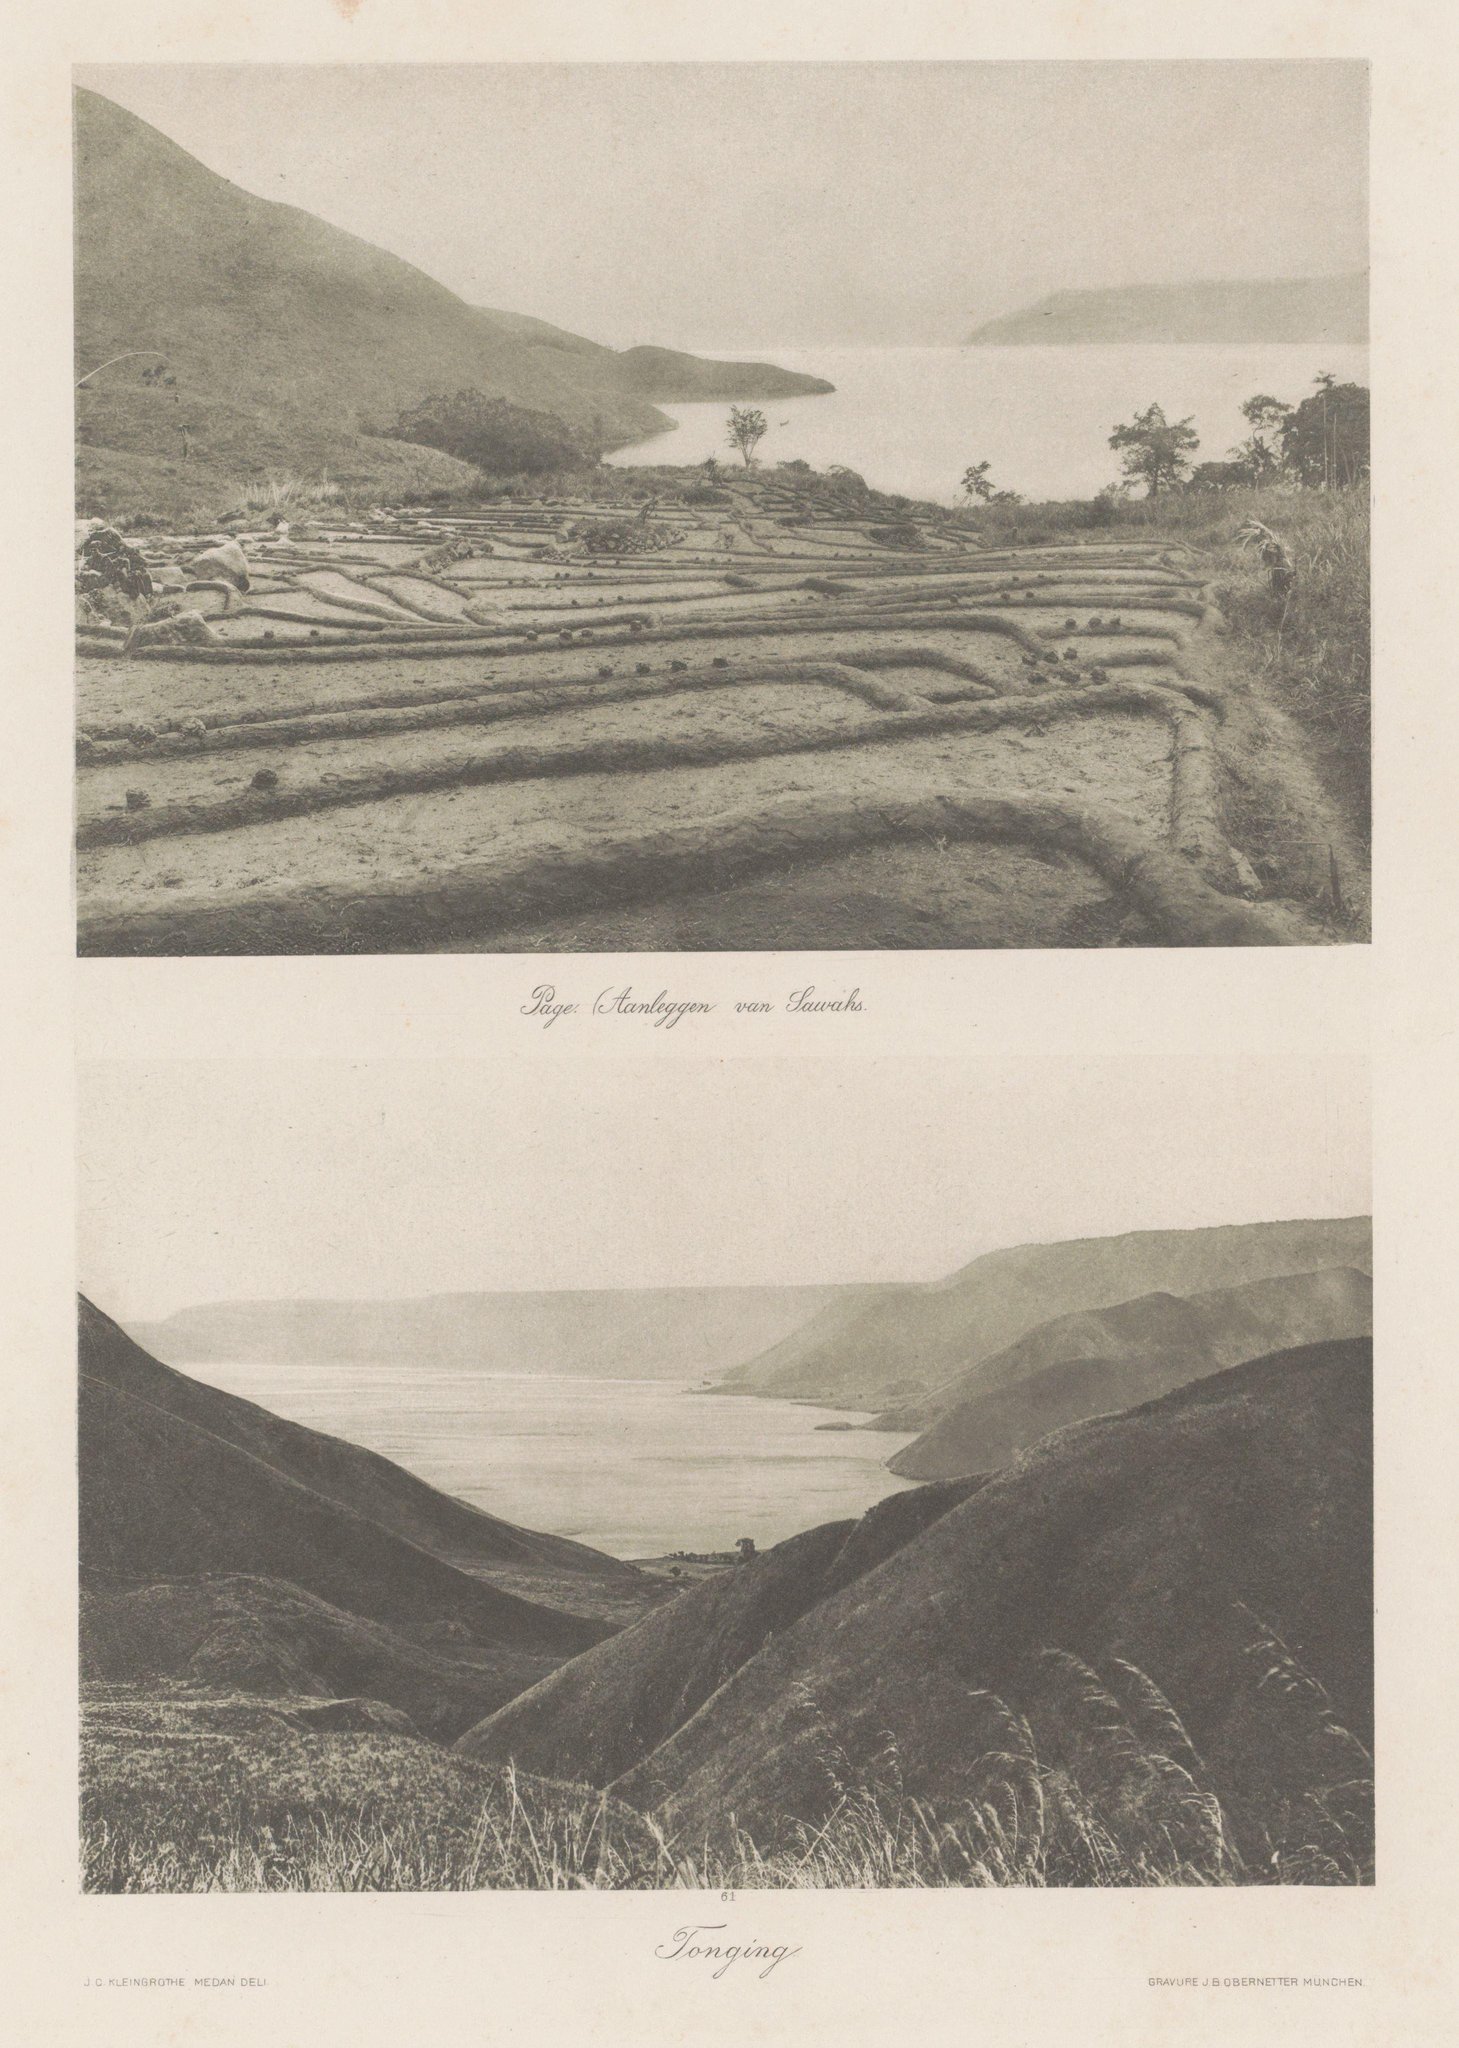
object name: photomechanical print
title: Page. (aanleggen van Sawahs (boven), Tonging (onder)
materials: paper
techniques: photoaquatint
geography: sumatra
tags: gulf, bay (+ landscape with figures, staffage), sawahs, rice paddies, sumatra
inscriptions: number: ‘61’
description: Onderdeel van Album met heliogravures van Sumatra's oostkust.